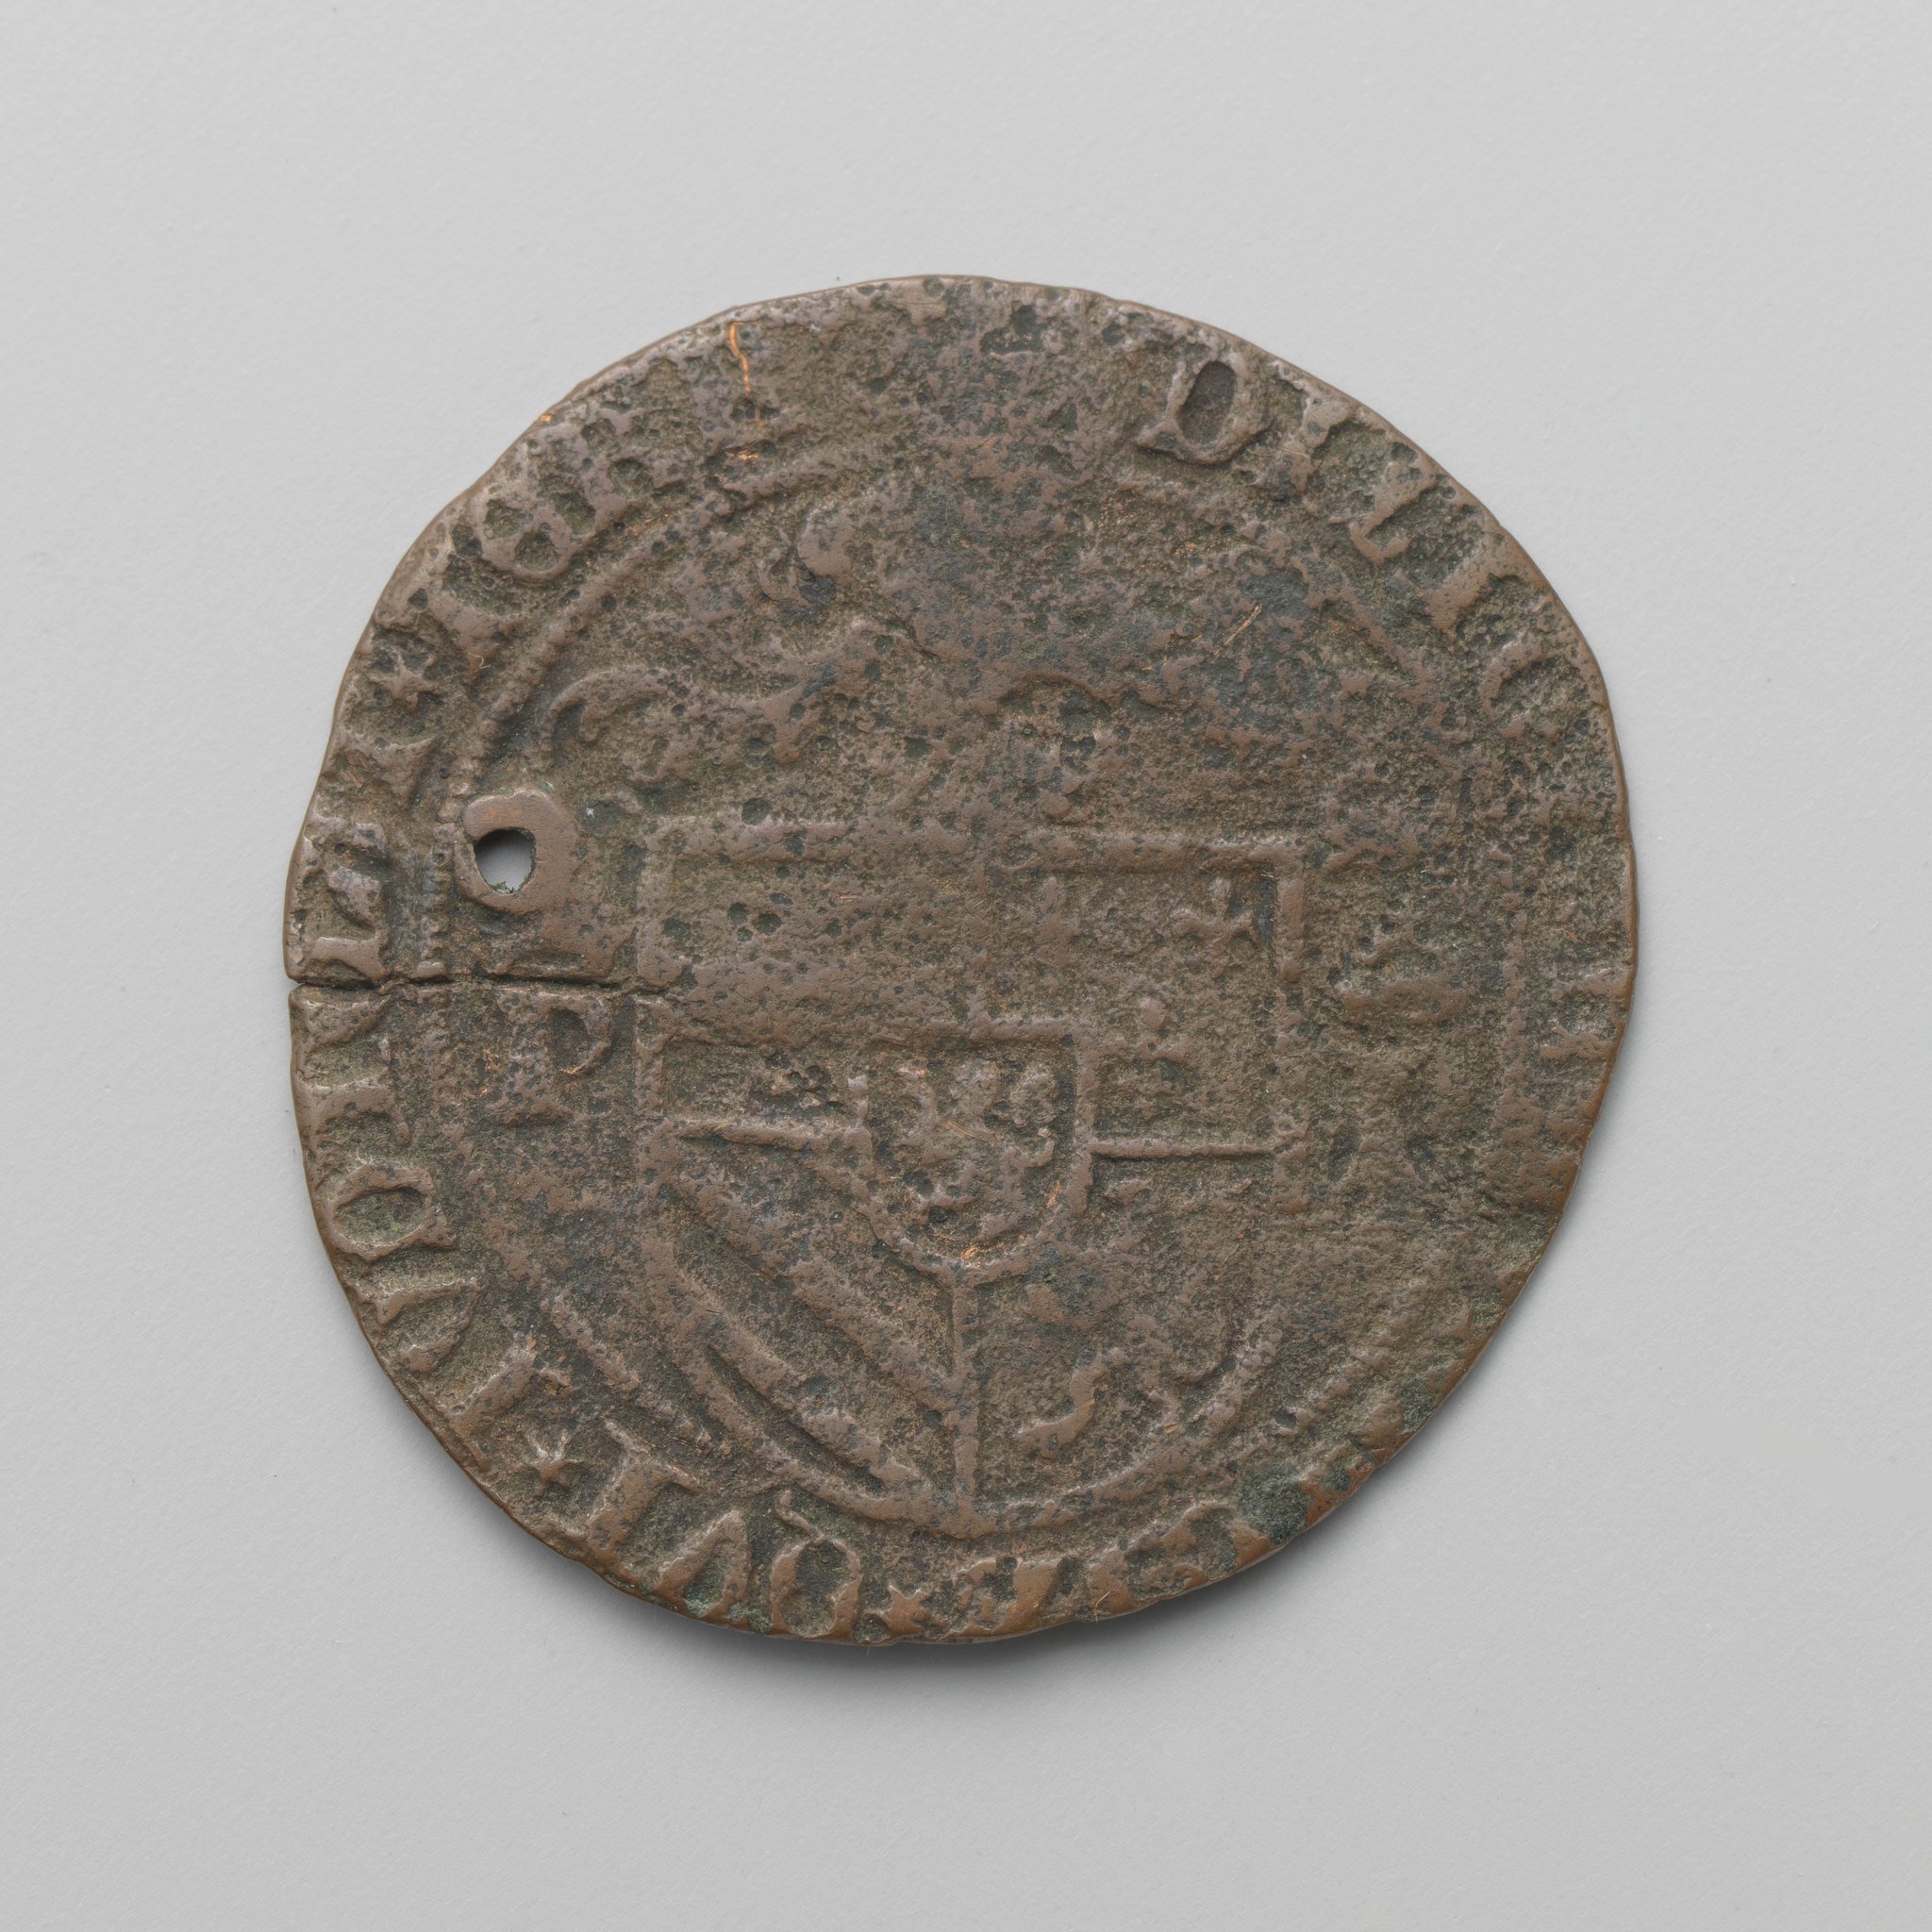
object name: jeton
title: Filips de Schone, hertog van Bourgondie en Johanna, prinses van Castillie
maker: Anonymous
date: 1502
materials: copper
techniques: striking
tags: bruges, filips de schone (hertog van bourgondië)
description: Koperen penning met gat erin. Voorzijde: vrouw met vuurslag in linkerhand, staande temidden van margrieten binnen omschrift. Keerzijde: wapenschild, geflankeerd door twee gekroonde letters P onder gekroonde helm binnen omschrift